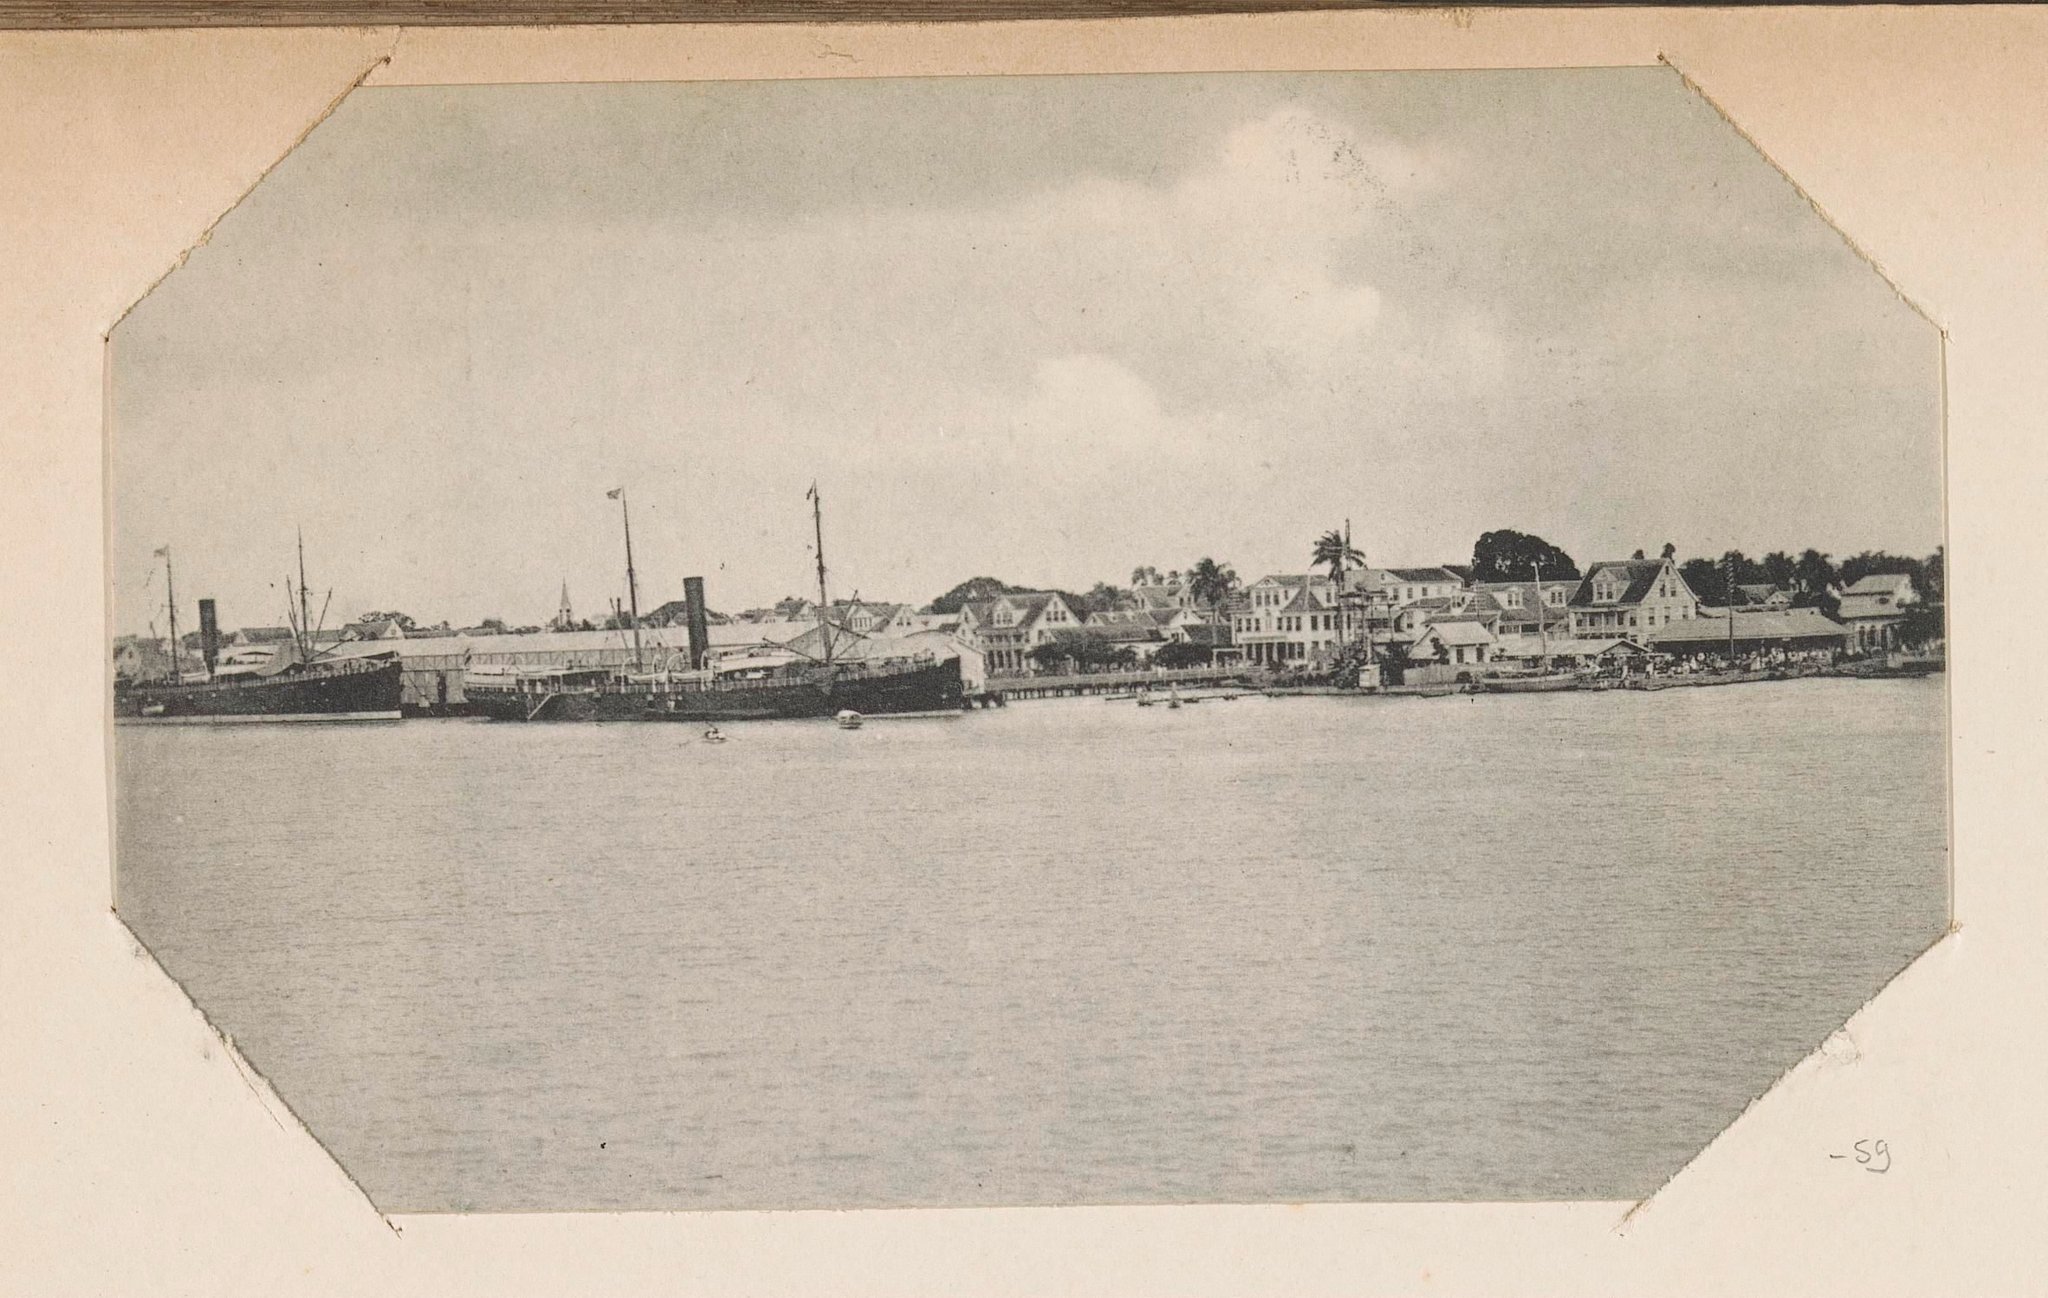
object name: ansichtkaart, prentbriefkaart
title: Waterkant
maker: Anonymous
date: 1900-1910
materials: cardboard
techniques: photograph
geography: paramaribo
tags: pier, quay, wharf, prospect of city, town panorama, silhouette of city (+ city(-scape) with figures, staffage)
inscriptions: serial number: ‘No. 115. Uitgevers C. Kersten & Co., Paramaribo’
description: Gezicht vanaf het water op de kade met schepen van de Koninklijke West-Indische Maildienst aan de Waterkant te Paramaribo. Onderdeel van een verzameling van 68 briefkaarten uit Suriname, bijeengebracht in een album als aandenken aan een verblijf in Suriname in september 1911.